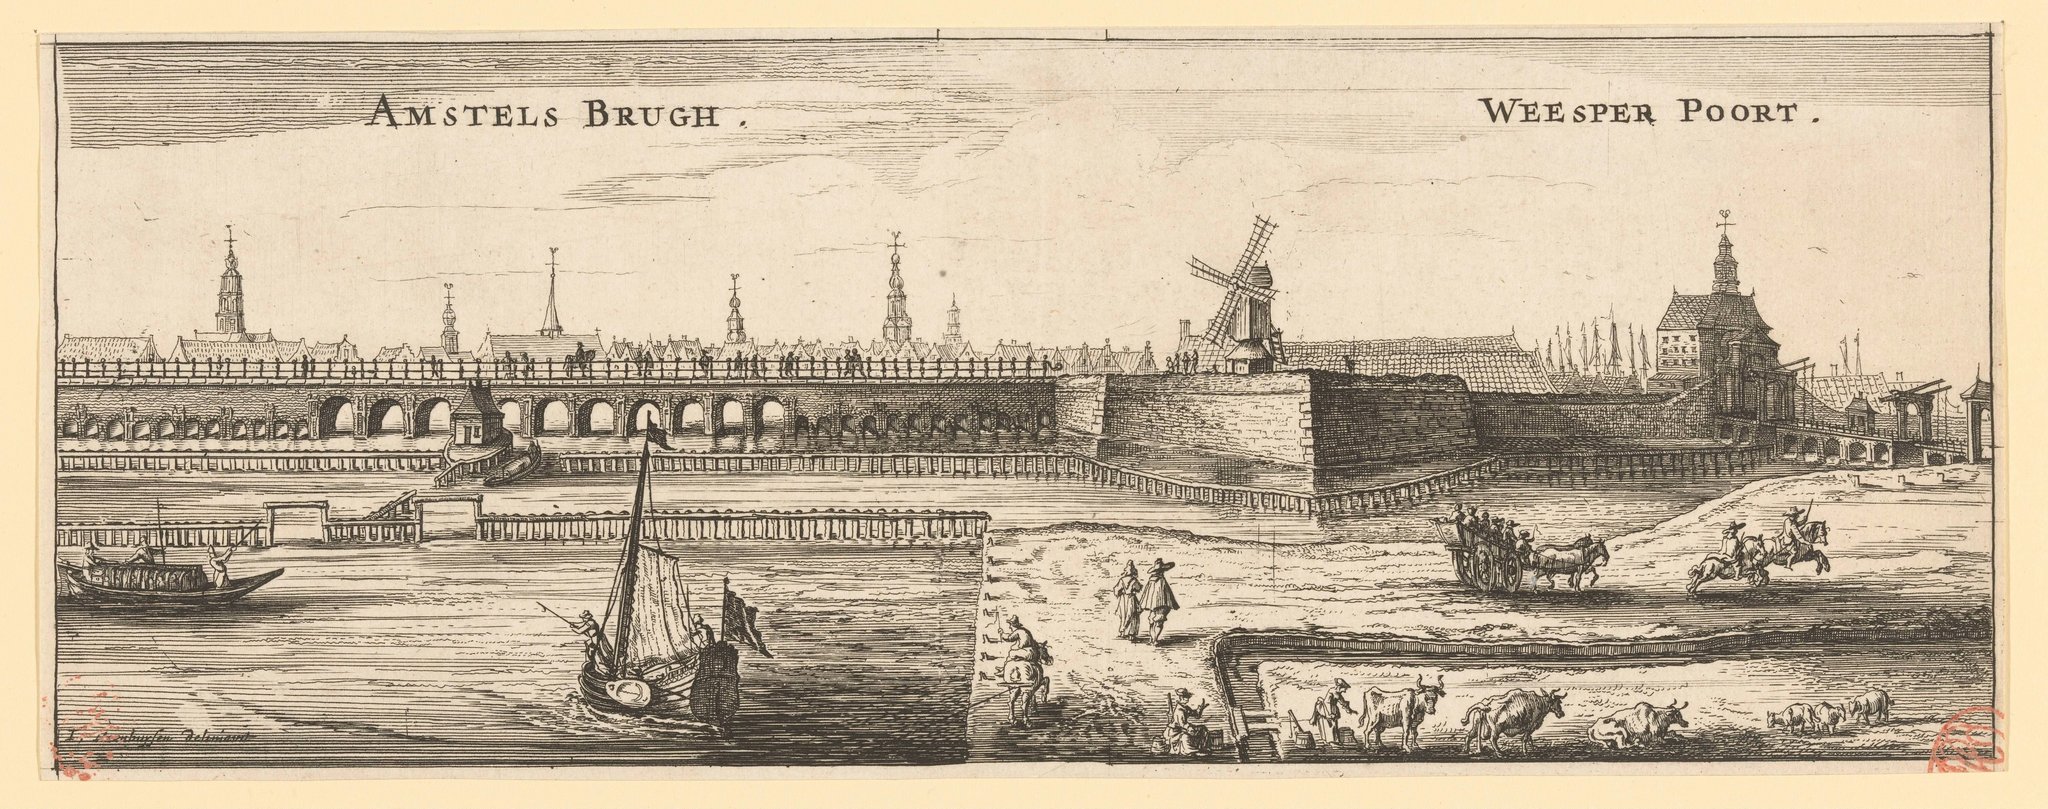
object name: book illustration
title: Amstels Brugh / Weesper Poort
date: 1664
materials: paper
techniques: engraving, etching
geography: amsterdam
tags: bridge in city across river, canal, etc. (+ city(-scape) with figures, staffage), city-gate, canals, waters (in city) (+ city(-scape) with figures, staffage)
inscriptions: collector's mark: Lugt 195, collector's mark: Lugt 195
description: Huidige staat van prent ook gebruikt in: Fockens, Melchior. Beschrijving Der wijdt-vermaarde Koop-stadt Amstelredam, Van haar eerste beginselen, zedert den Jare 1203. oude Voorrechten, verscheyde Vergrootingenoude Voor-rechten, en verscheyde Vergrootingen (…). 3e druk. Amsterdam: Marcus Willemsz. Doornick, 1664. En in: Zesen, Philipp von. Beschrybung der Weidtberuhmde Kauf-Stadt Amstelredam / Beschreibung der Stadt Amsterdam darinnen von derselben ersten ursprunge bis auf gegenwartigen zustand (…). Amsterdam: Marcus Willemsz. Doornick, 1664. Tweede bekende staat (met toevoeging Franse titel) ook gebruikt in: Domselaer, Tobias en Isaac Commelin. Beschryvinge van Amsterdam : haar eerste oorspronk uyt den huyze der heeren van Aemstel en Aemstellant (…). 6 delen. Amsterdam: Marcus Willemsz van Doornick, 1665. Derde bekende staat (versneden tot twee platen, Amstelbrug linksboven genummerd: 69; Weesperpoort rechtsboven genummerd: 68) ook gebruikt in verschillende latere zeventiende- en achttiende-eeuwse publicaties.